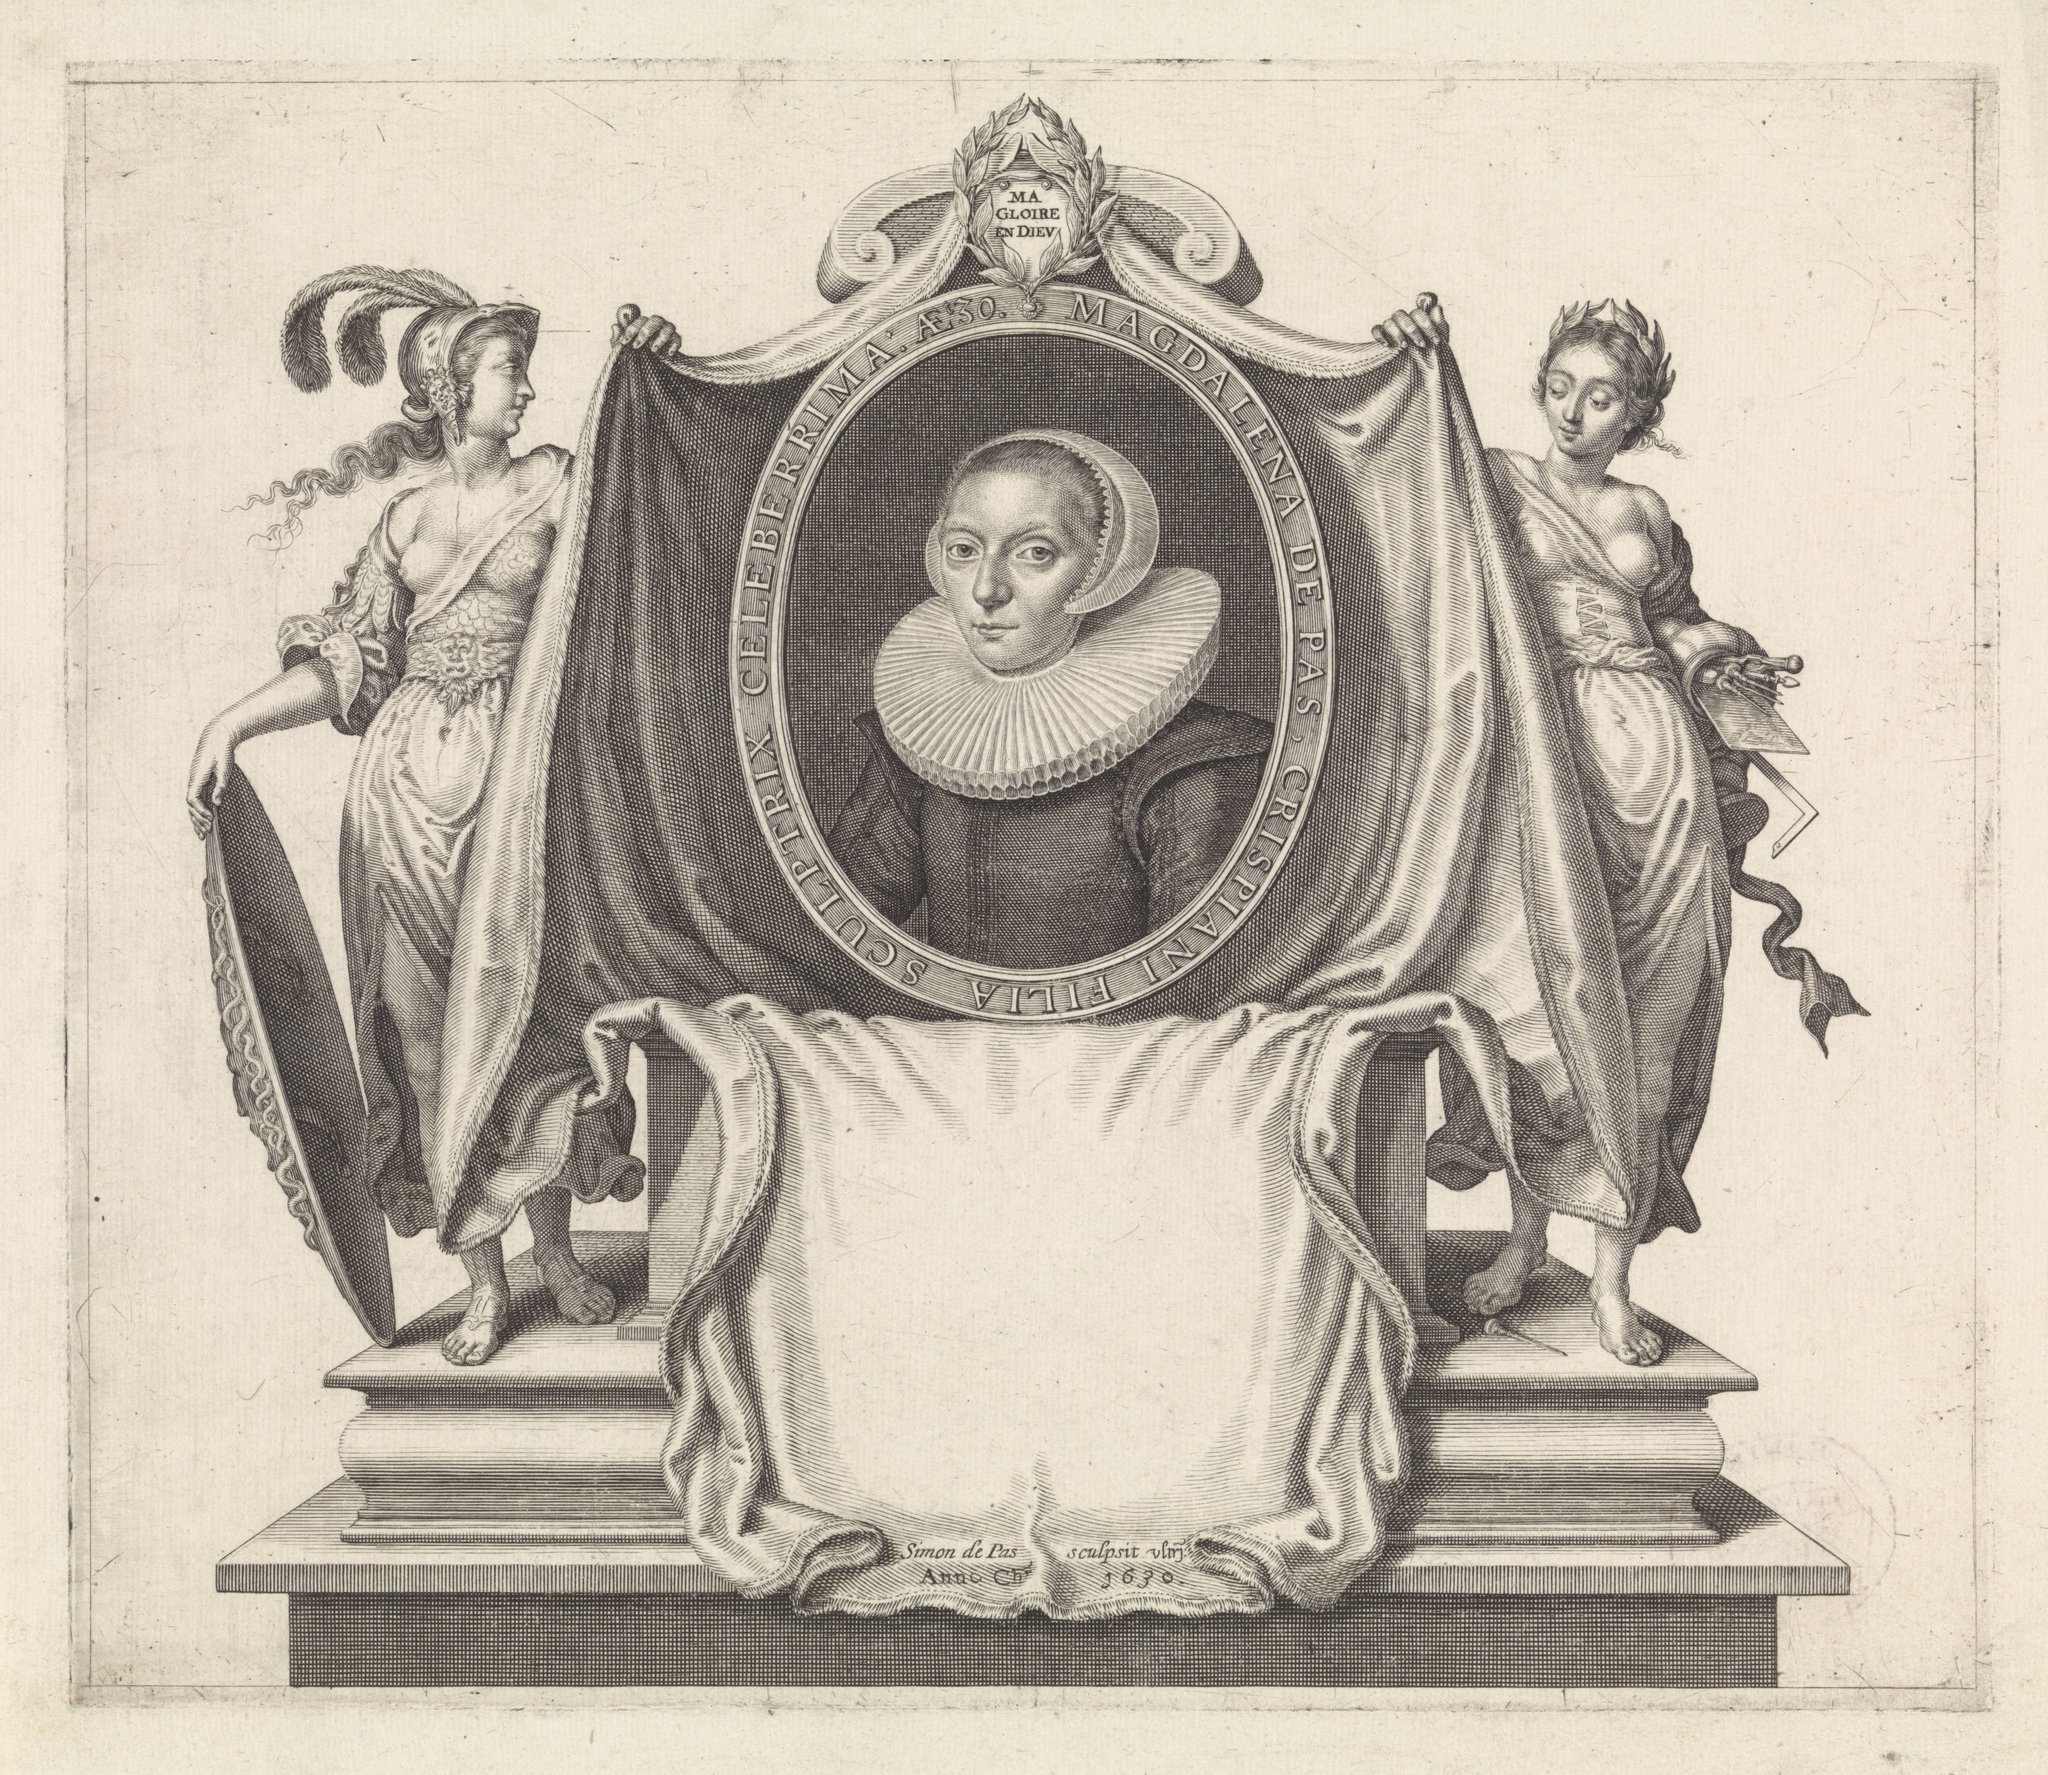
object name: print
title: Portrait of Magdalena de Passe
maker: simon van de passe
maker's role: print maker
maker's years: 1595-1647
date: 1630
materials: paper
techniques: engraving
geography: utrecht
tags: cologne, utrecht, print maker, magdalena van de passe, 'sculptura', symbolic representations, allegories and emblems ~ sculpture; 'scoltura' (ripa), specific aspects, allegorical aspects of minerva; minerva as patroness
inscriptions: collector's mark: Lugt 240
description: Magdalena was about thirty when her brother Simon proudly portrayed her. The border inscription praises her as a renowned female engraver. Magdalena’s likeness is flanked by the goddess Minerva, patron of the arts, and by the personification of the art of engraving holding the main attributes of the craft: a copper plate and burins, the sharp instruments used to incise the representations into the copper.